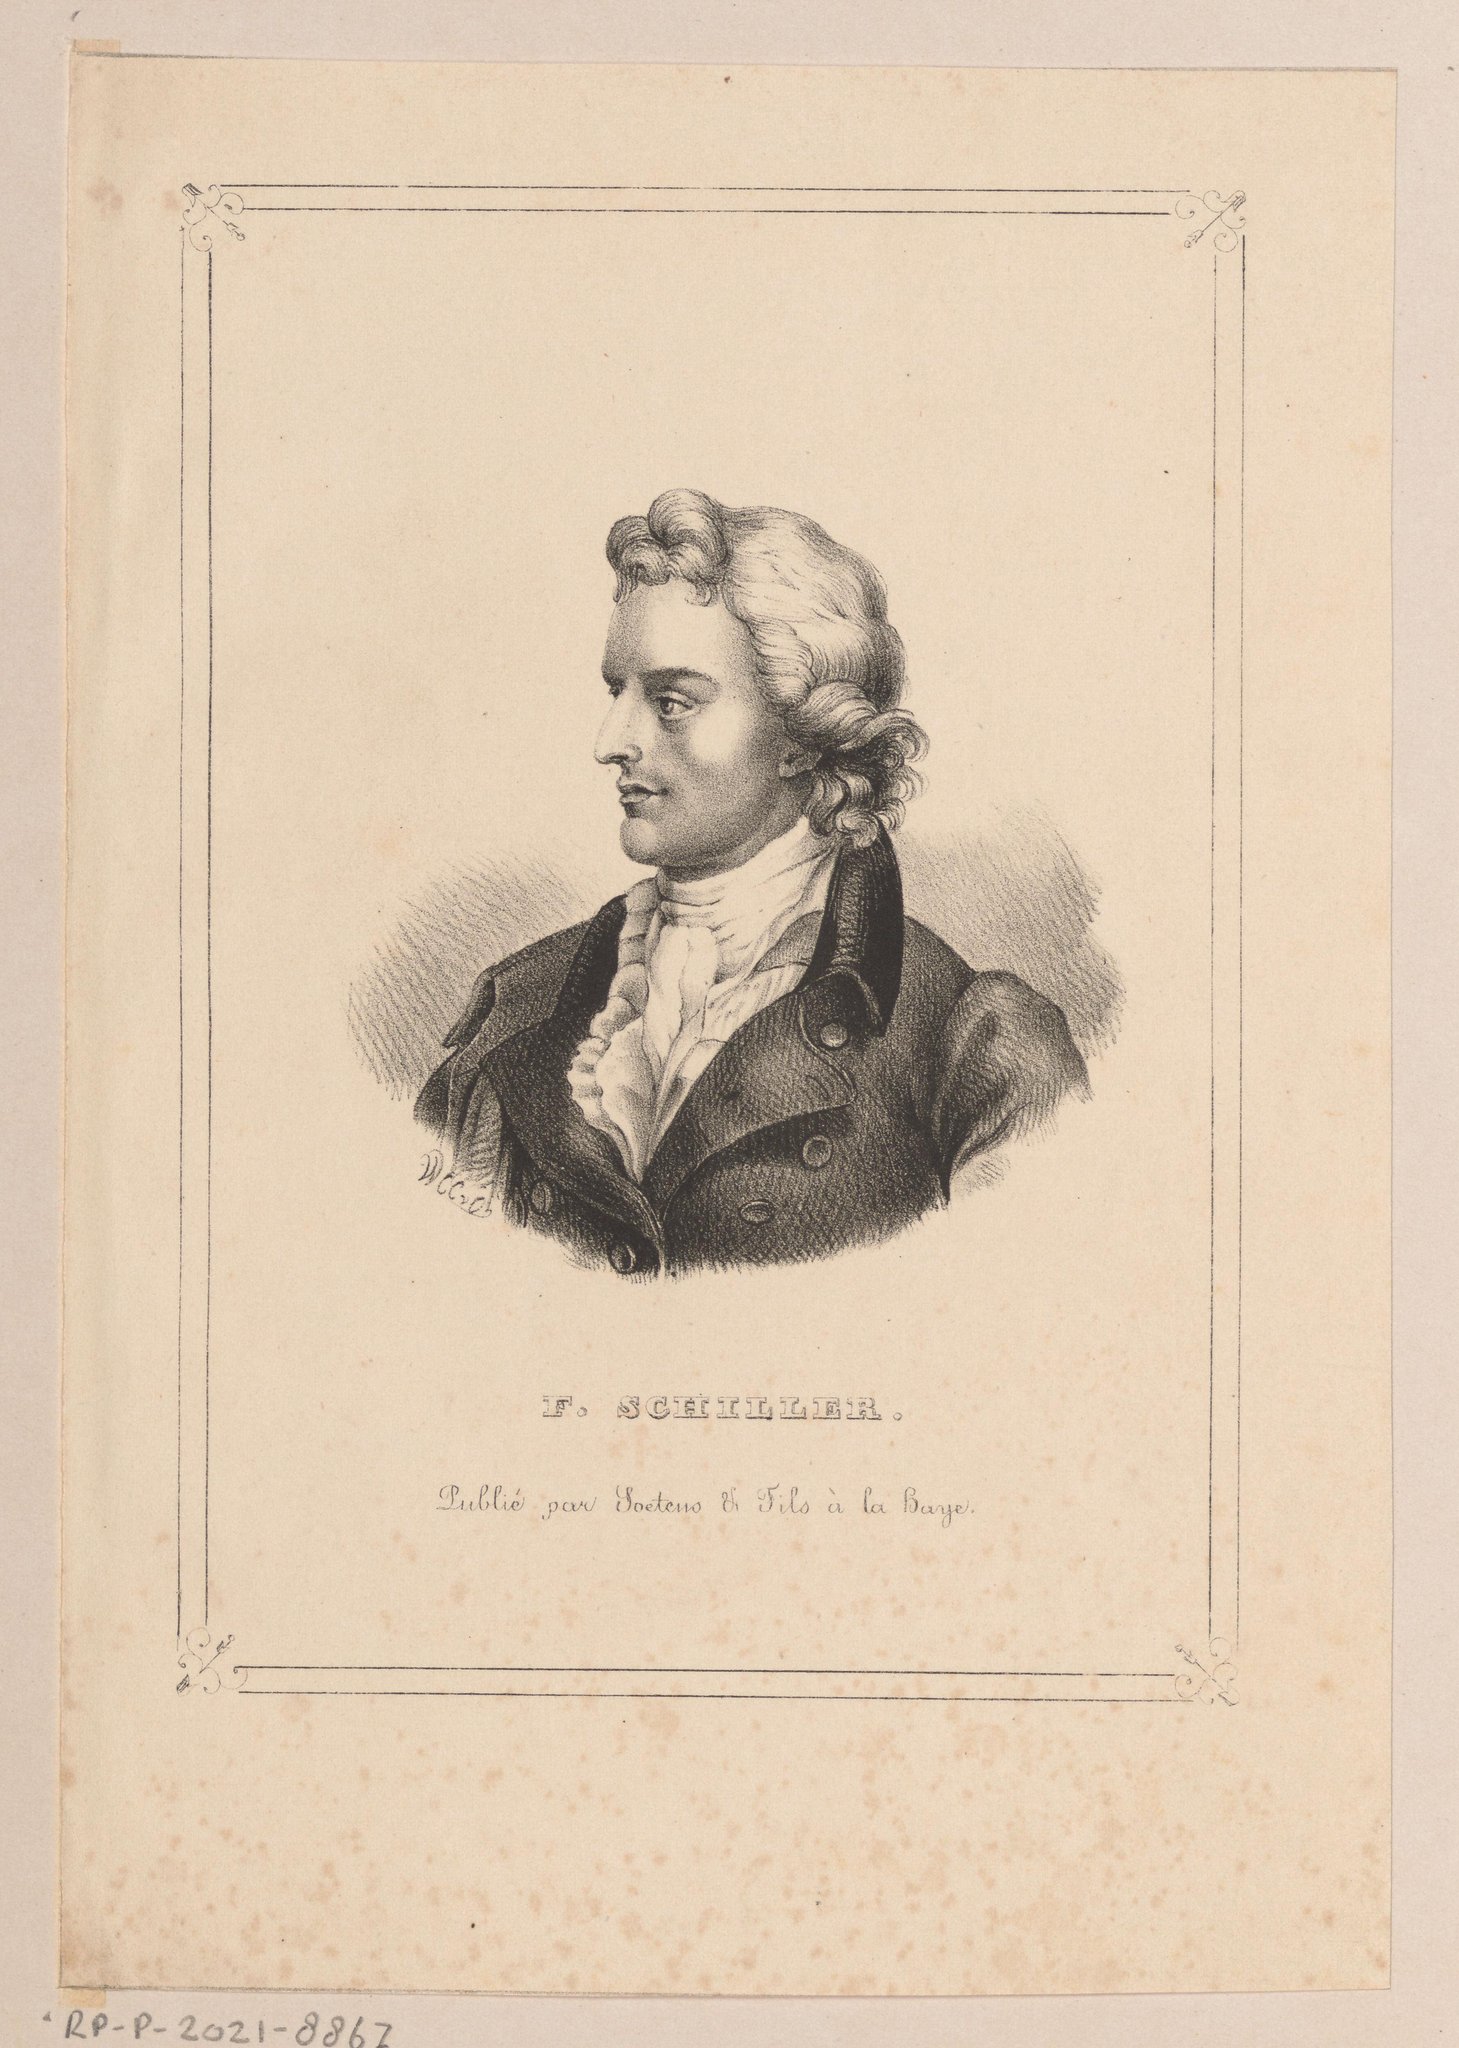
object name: print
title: Portret van Friedrich von Schiller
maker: wilhelmus cornelis chimaer van oudendorp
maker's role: print maker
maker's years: 1822-1873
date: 1837-1840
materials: paper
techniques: lithograph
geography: the hague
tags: friedrich von schiller, scholar, philosopher, historical persons, portrait of a writer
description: Deze prent maakt mogelijk deel uit van een serie uitgegeven door Soetens et Fils omstreeks 1838, opgedragen aan de Prins van Oranje. In de 'Prospectus en Inteekenlijst' stond vermeld dat de serie bestond uit een onbepaald aantal portretten, waarvan er drie of vier per maand verschenen.